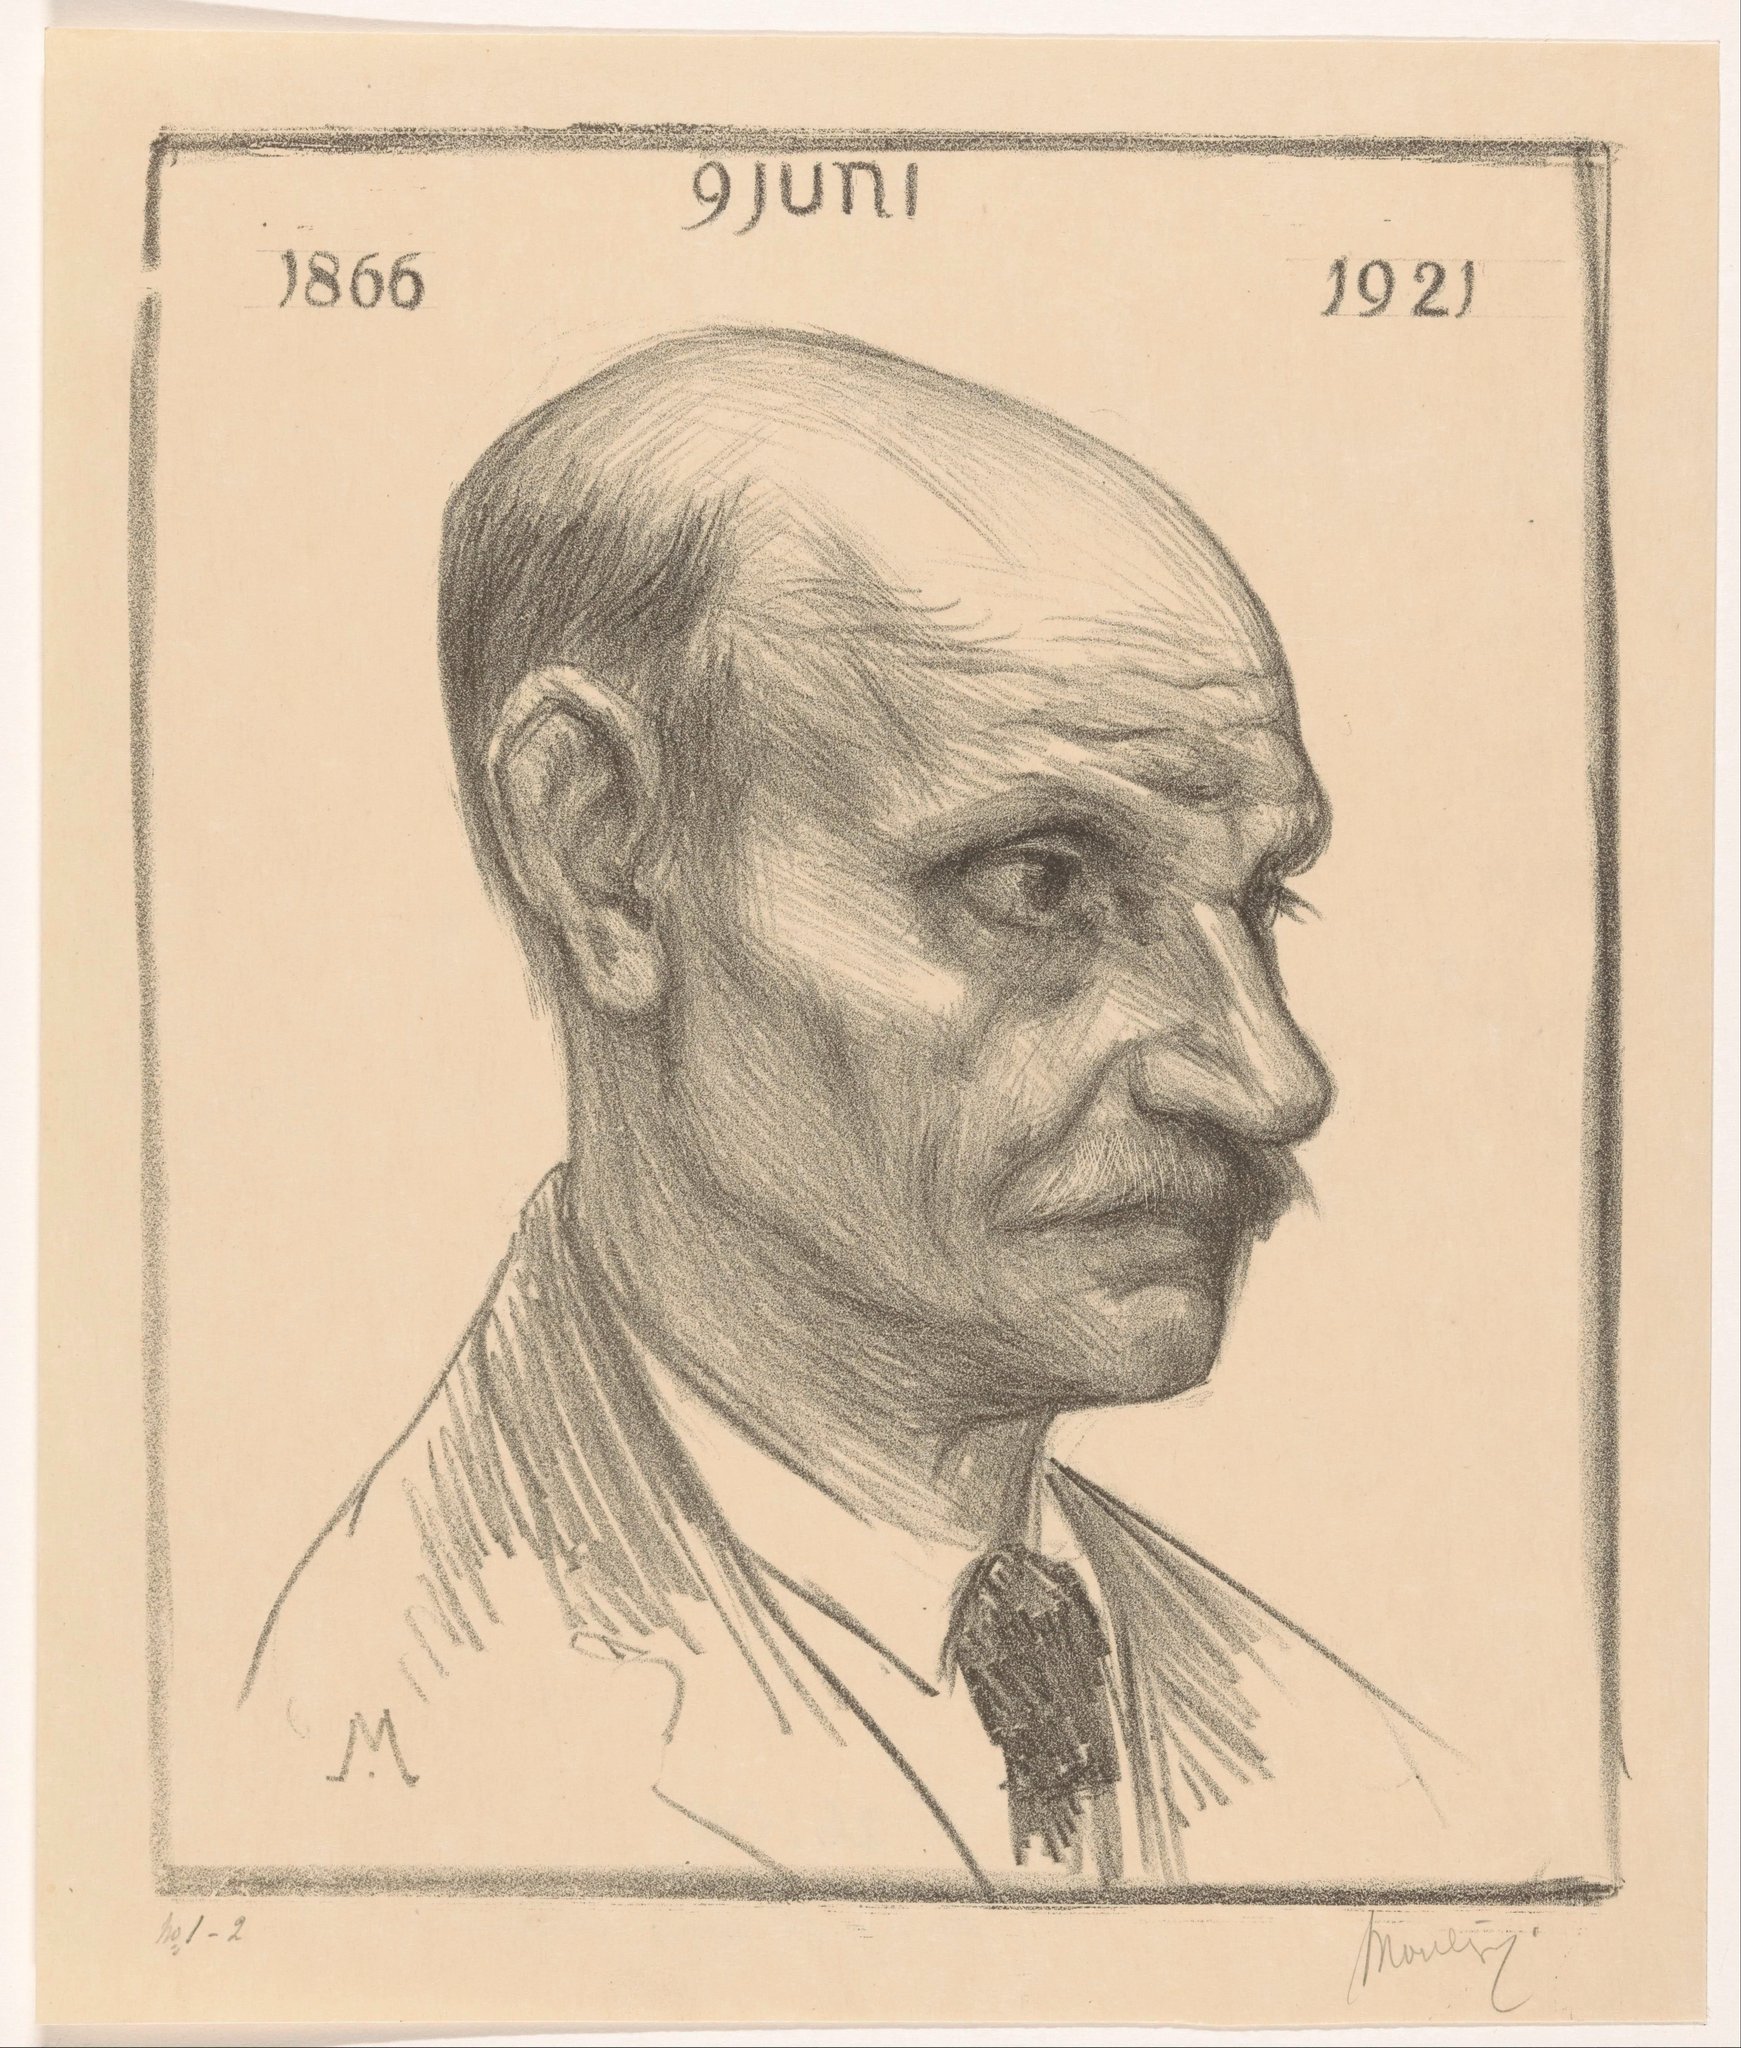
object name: print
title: Portret van een onbekende man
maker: simon moulijn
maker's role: draughtsman, print maker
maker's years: 1866-1948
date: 1921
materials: paper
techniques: lithograph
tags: adult man, historical persons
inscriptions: collector's mark: Lugt 2228, annotation: ‘De steenenslijper, Chr. Schilder-[...] op z'n 55 jarig jubileum.’